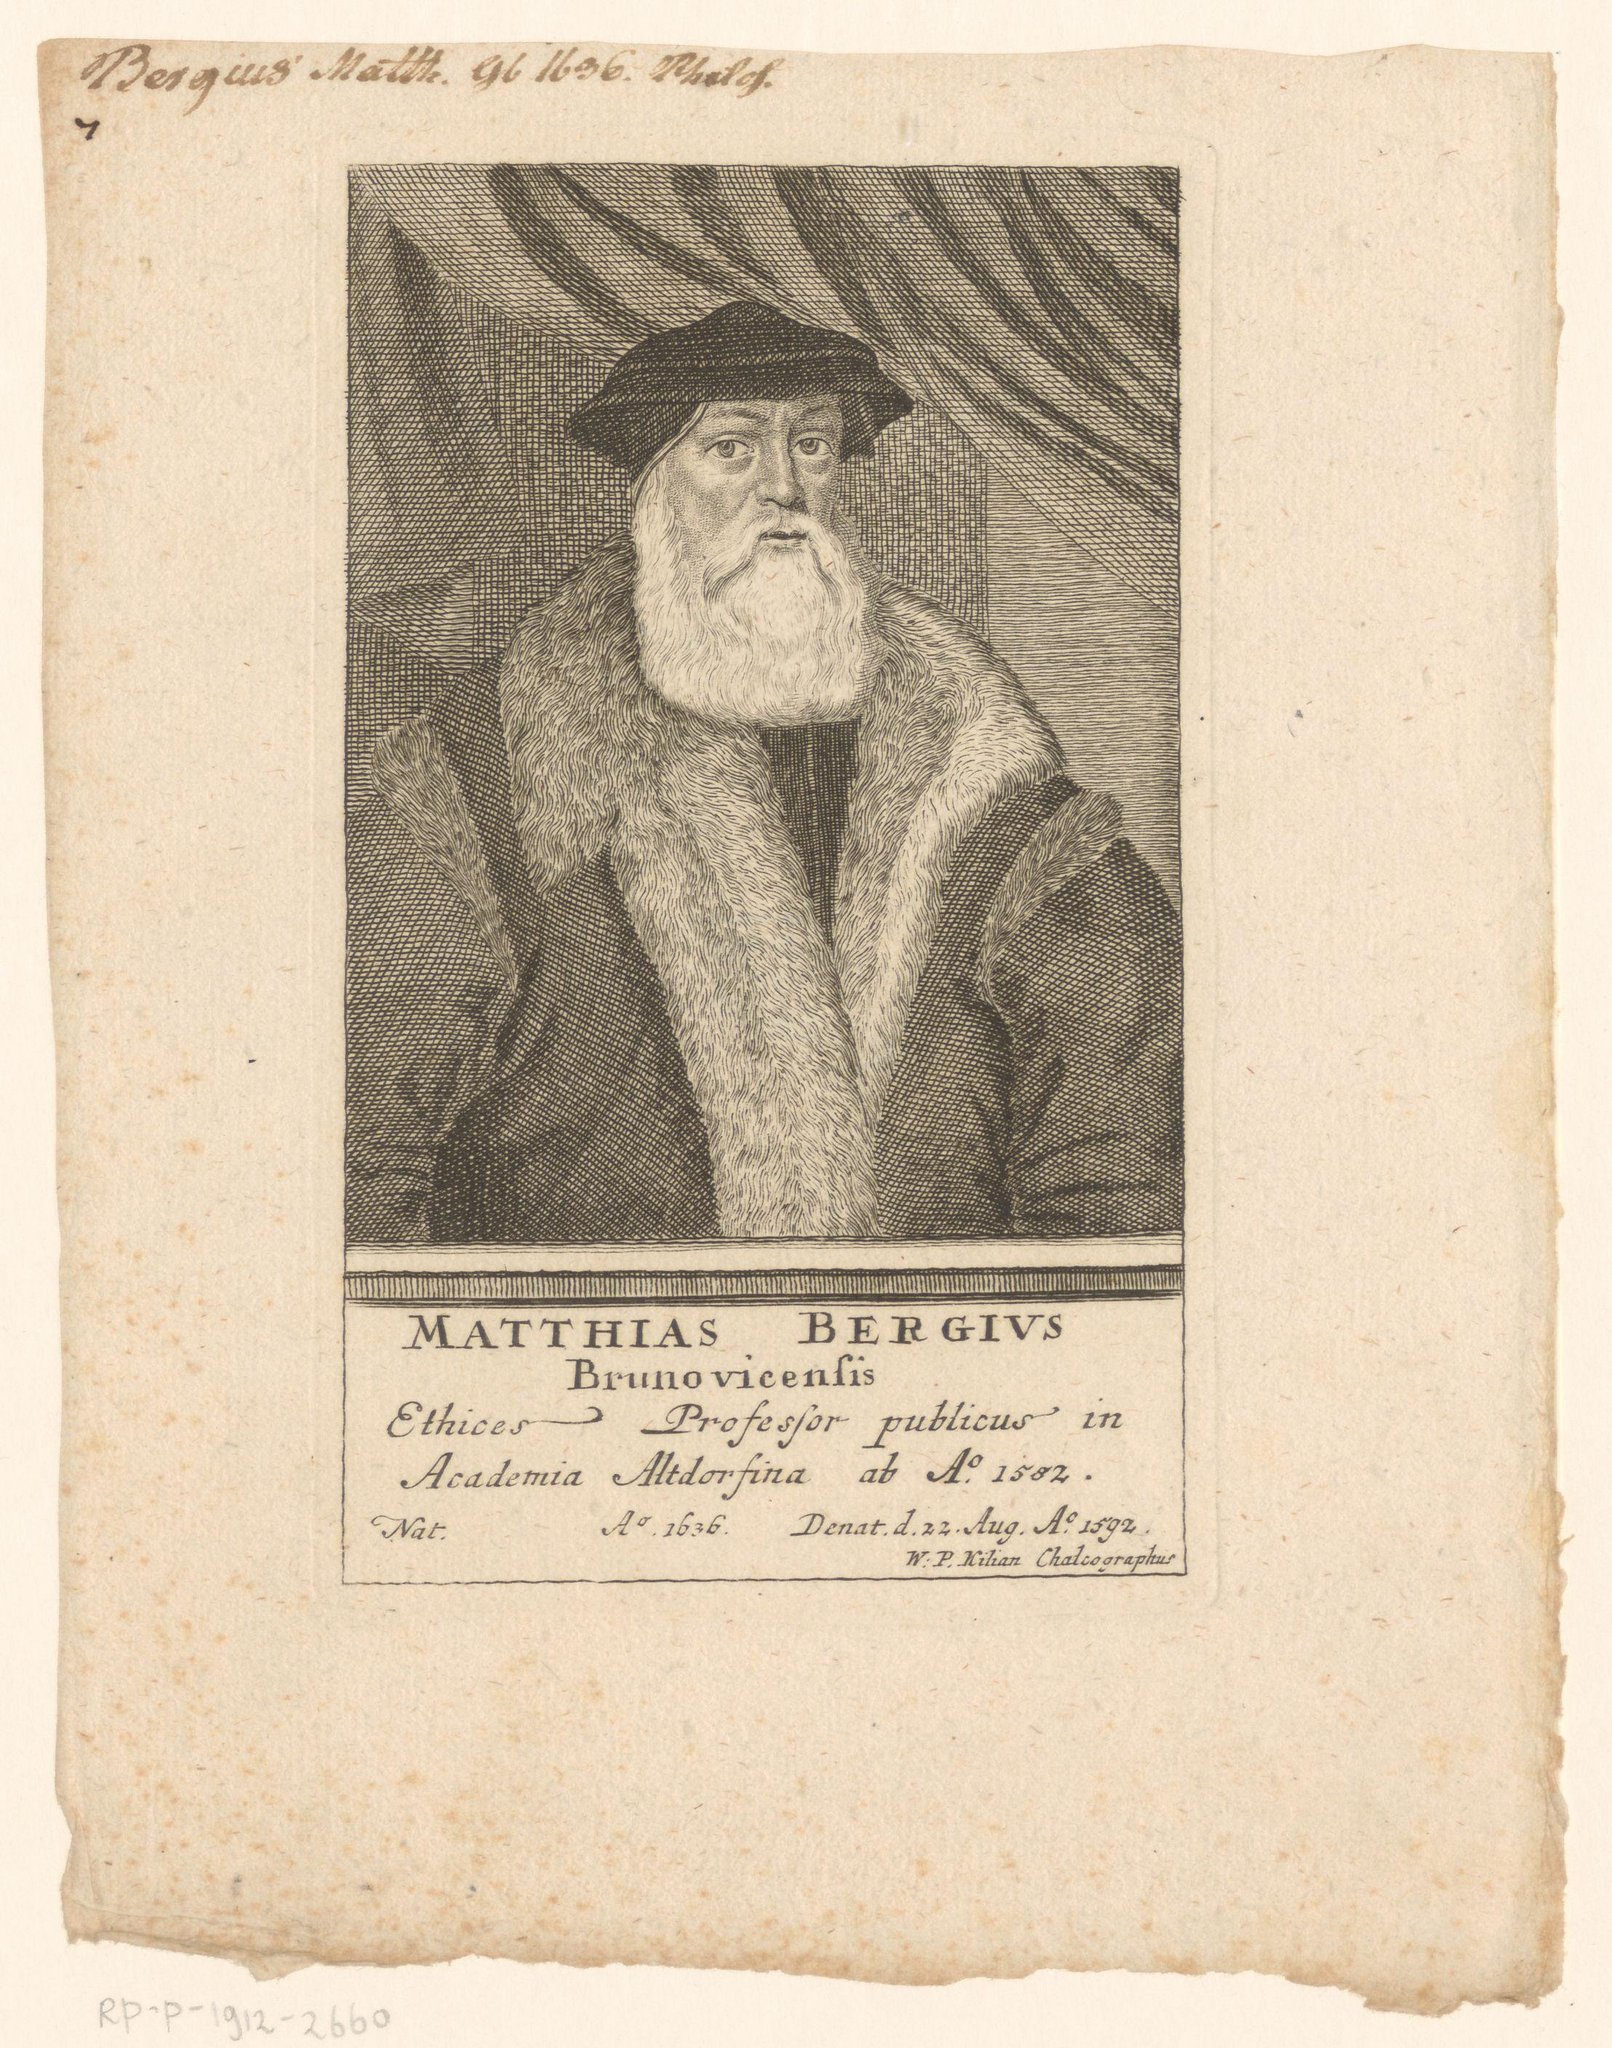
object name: print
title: Portret van Matthias Berg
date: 1669-1732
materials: paper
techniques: engraving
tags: philology (+ portrait of scholar, scientist), historical persons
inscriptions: collector's mark: Lugt 2228